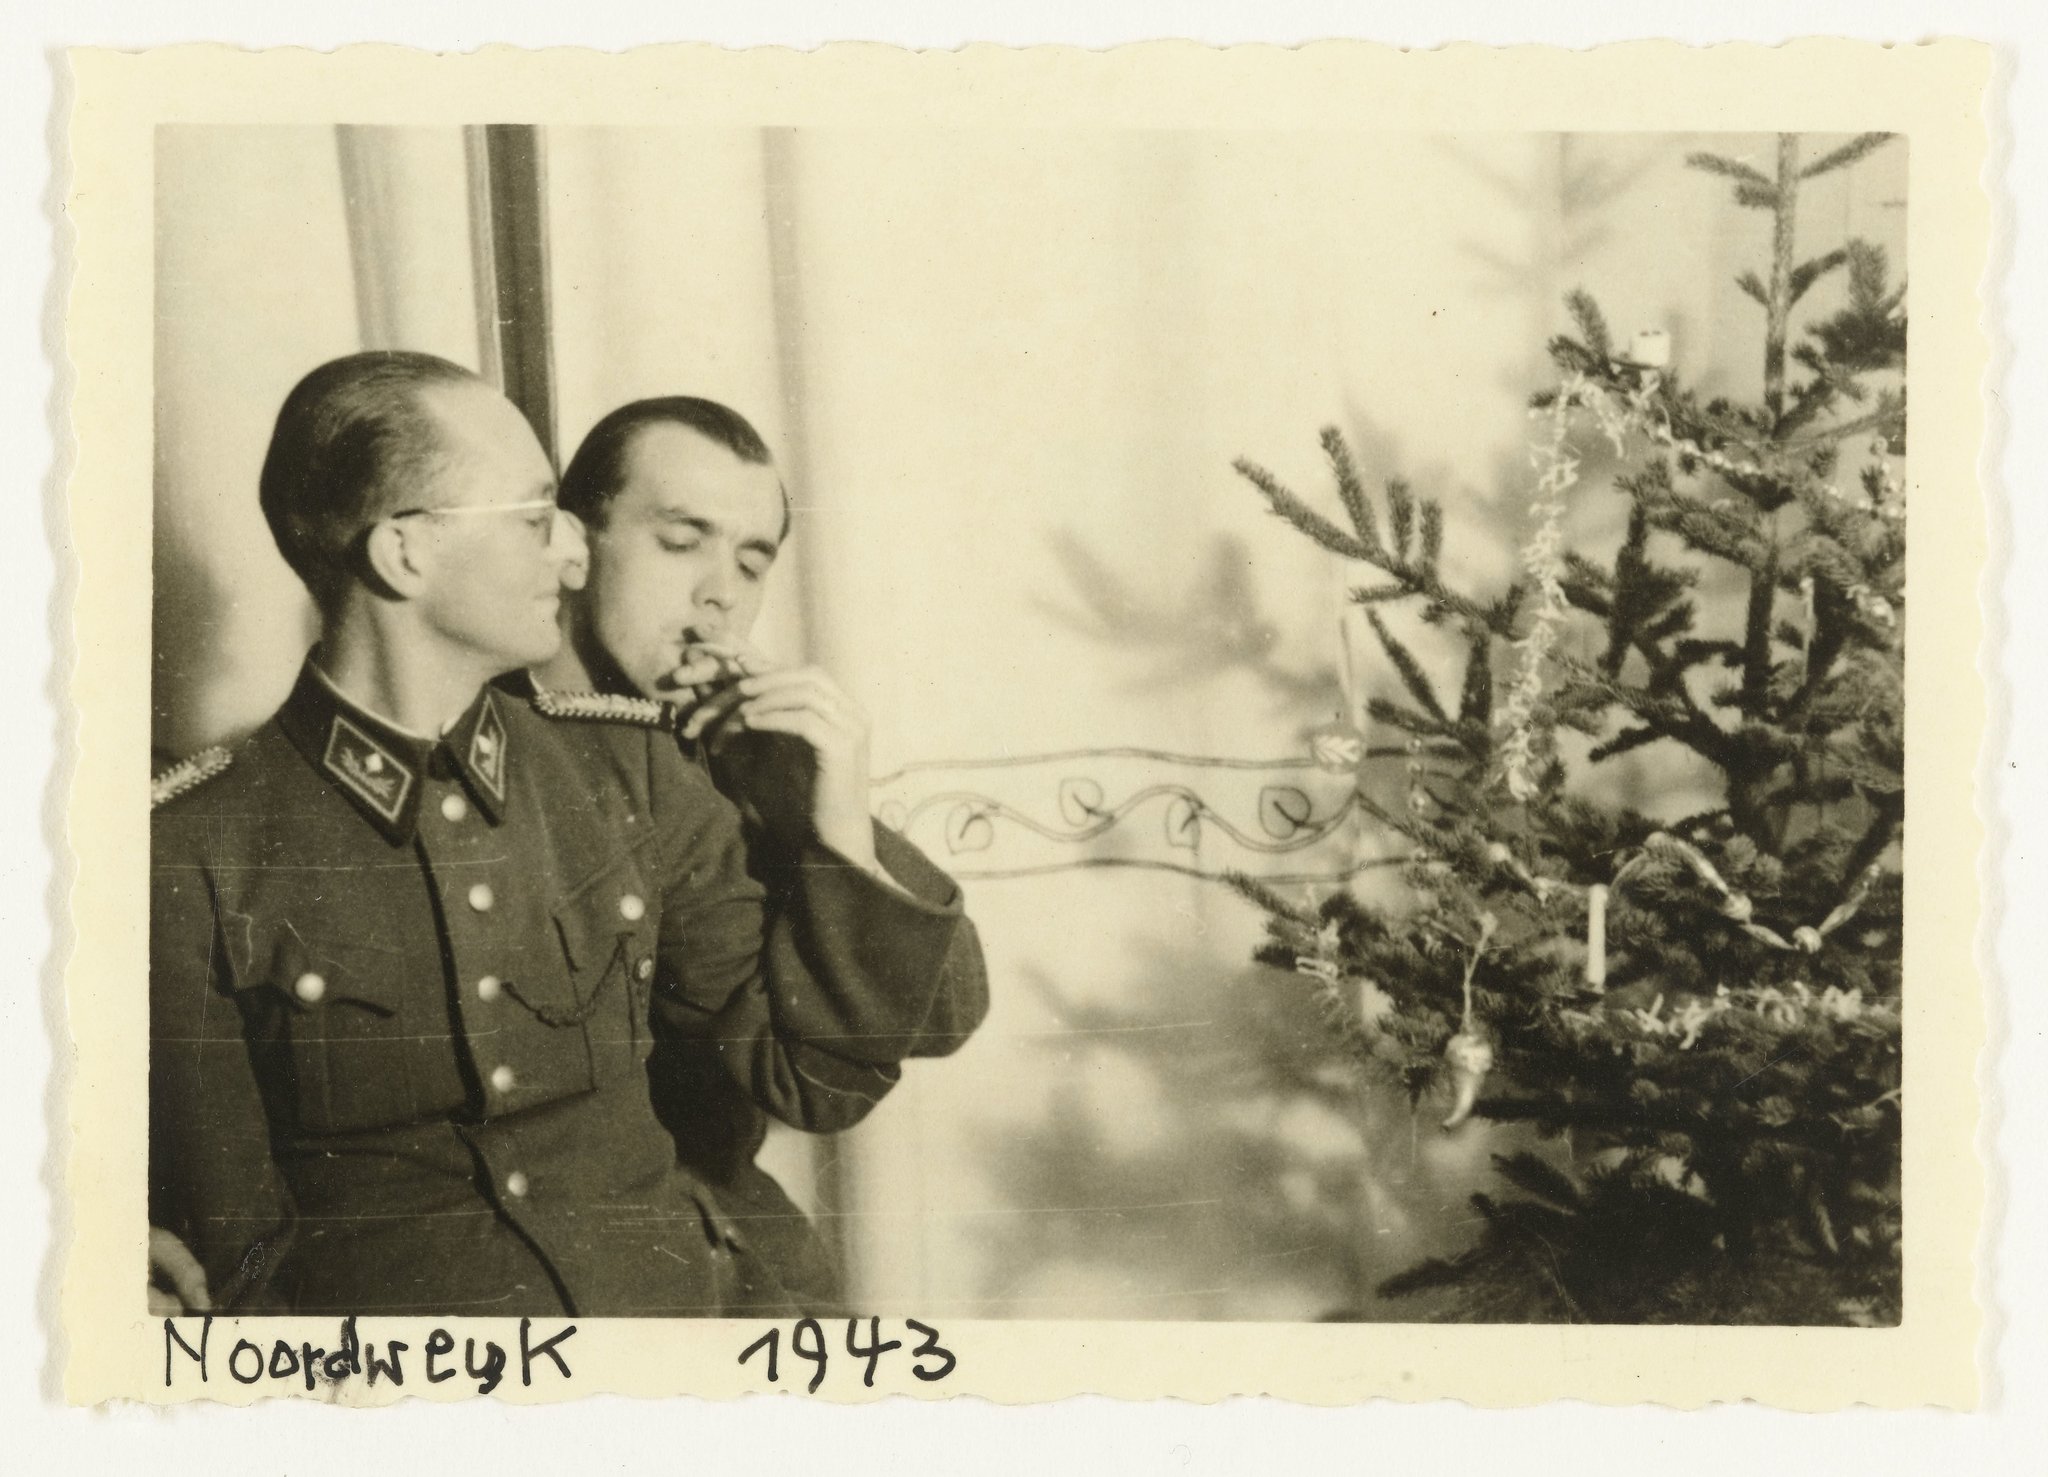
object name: photograph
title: Wehrmacht soldaten bij een kerstboom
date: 1912-1943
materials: photographic support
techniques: gelatin silver print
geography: noordwijk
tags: christmas tree, occupation ~ war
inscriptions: stamp: ‘Foto G.J. de Roos’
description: Noordwijk: twee Duitse militairen staan bij een kerstboom. De een geeft de ander een vuurtje. Achterop staat: Weihnachten 1943.